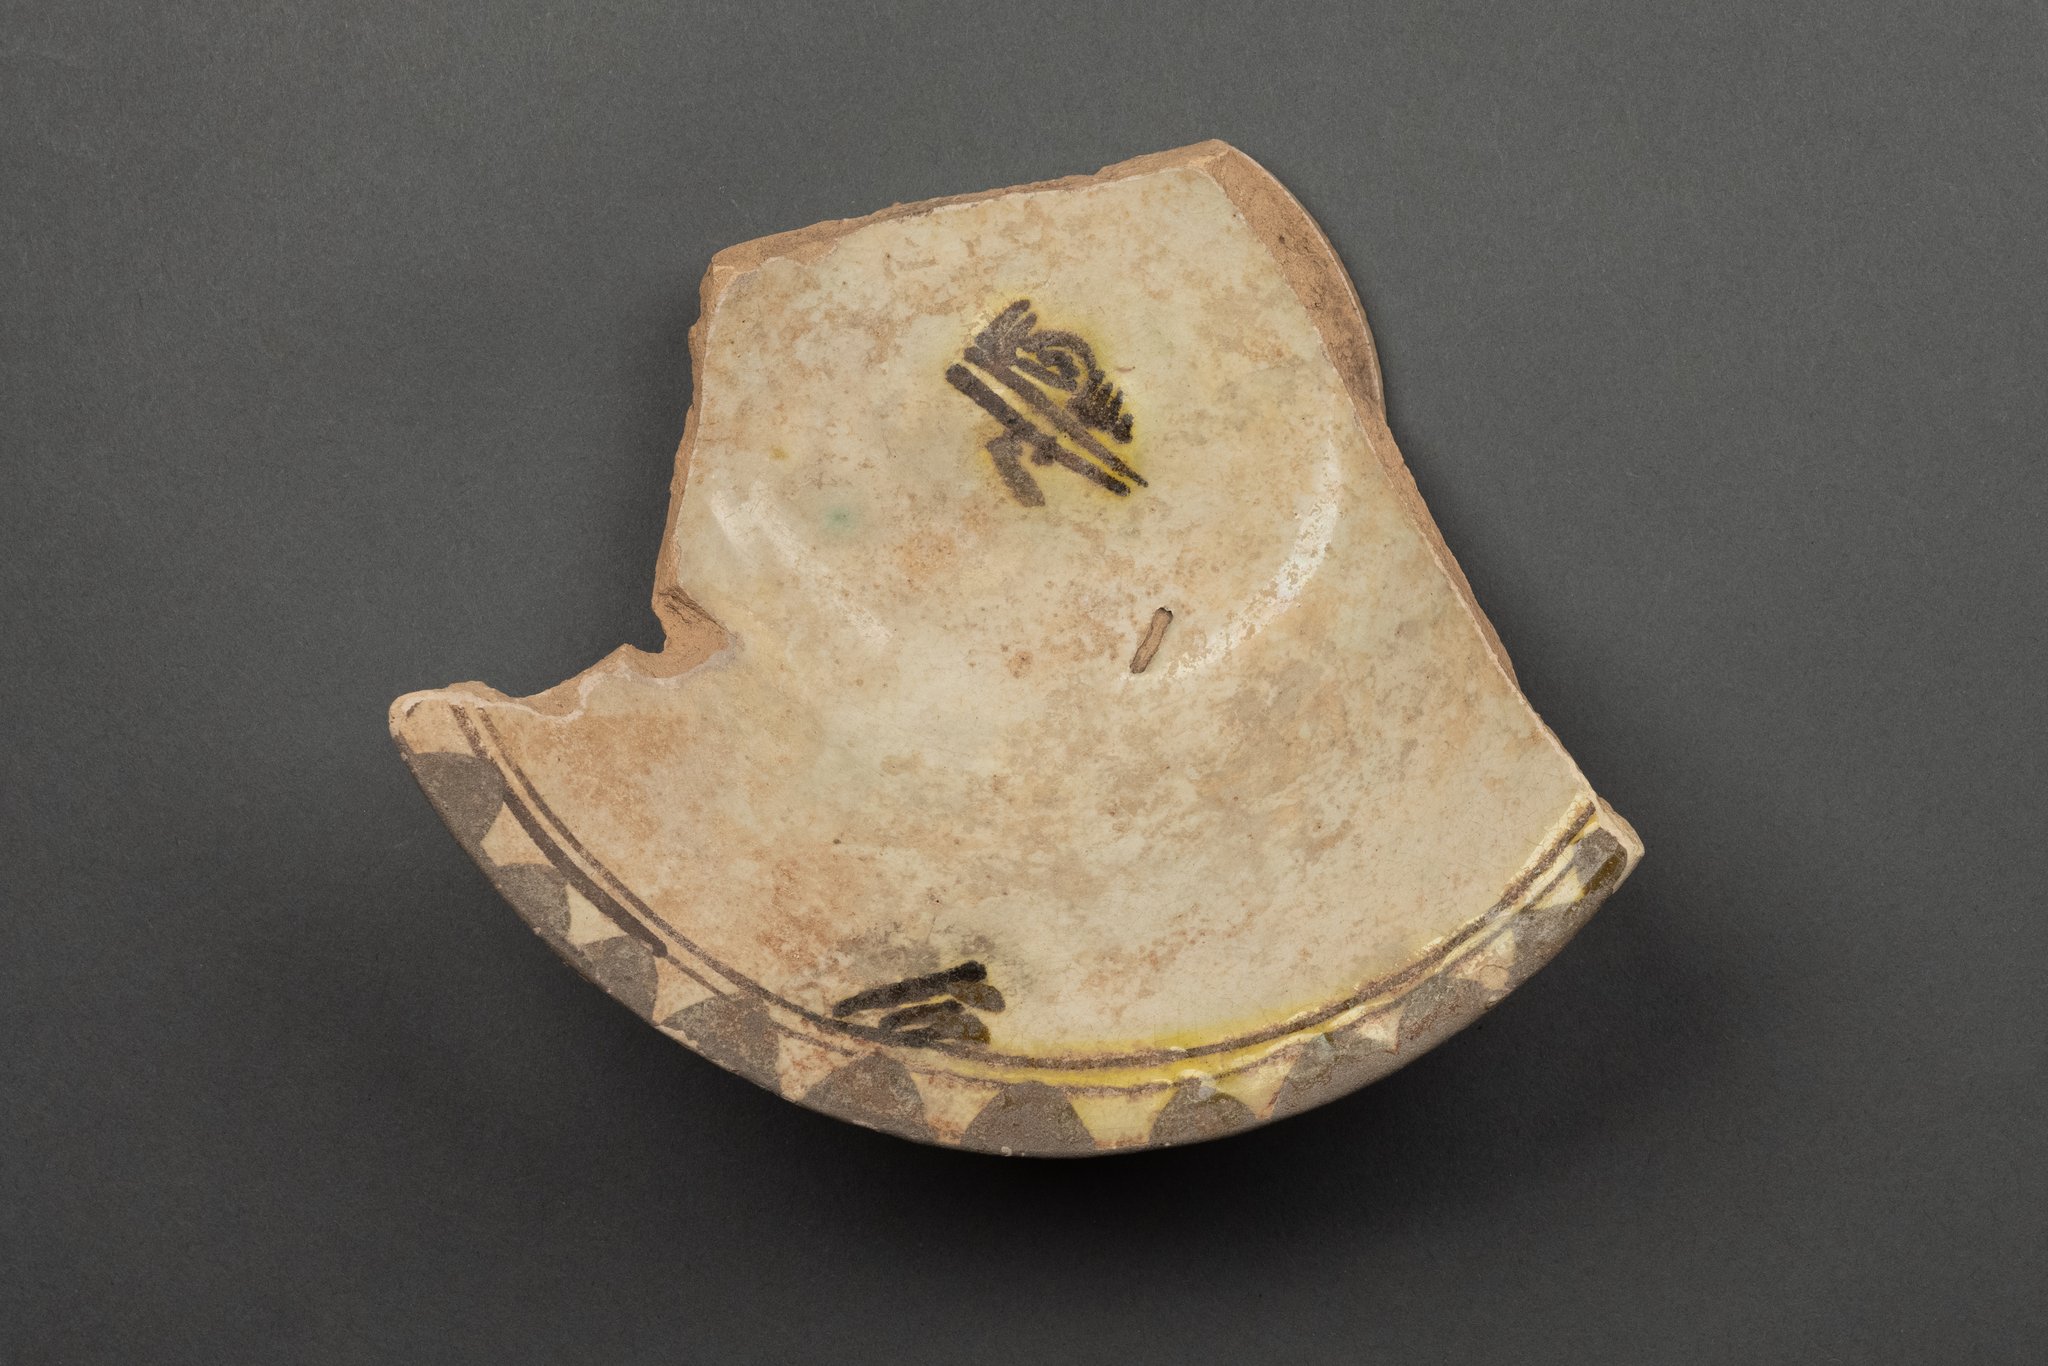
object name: fragment of a bowl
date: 801-1000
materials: earthenware, glaze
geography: iran